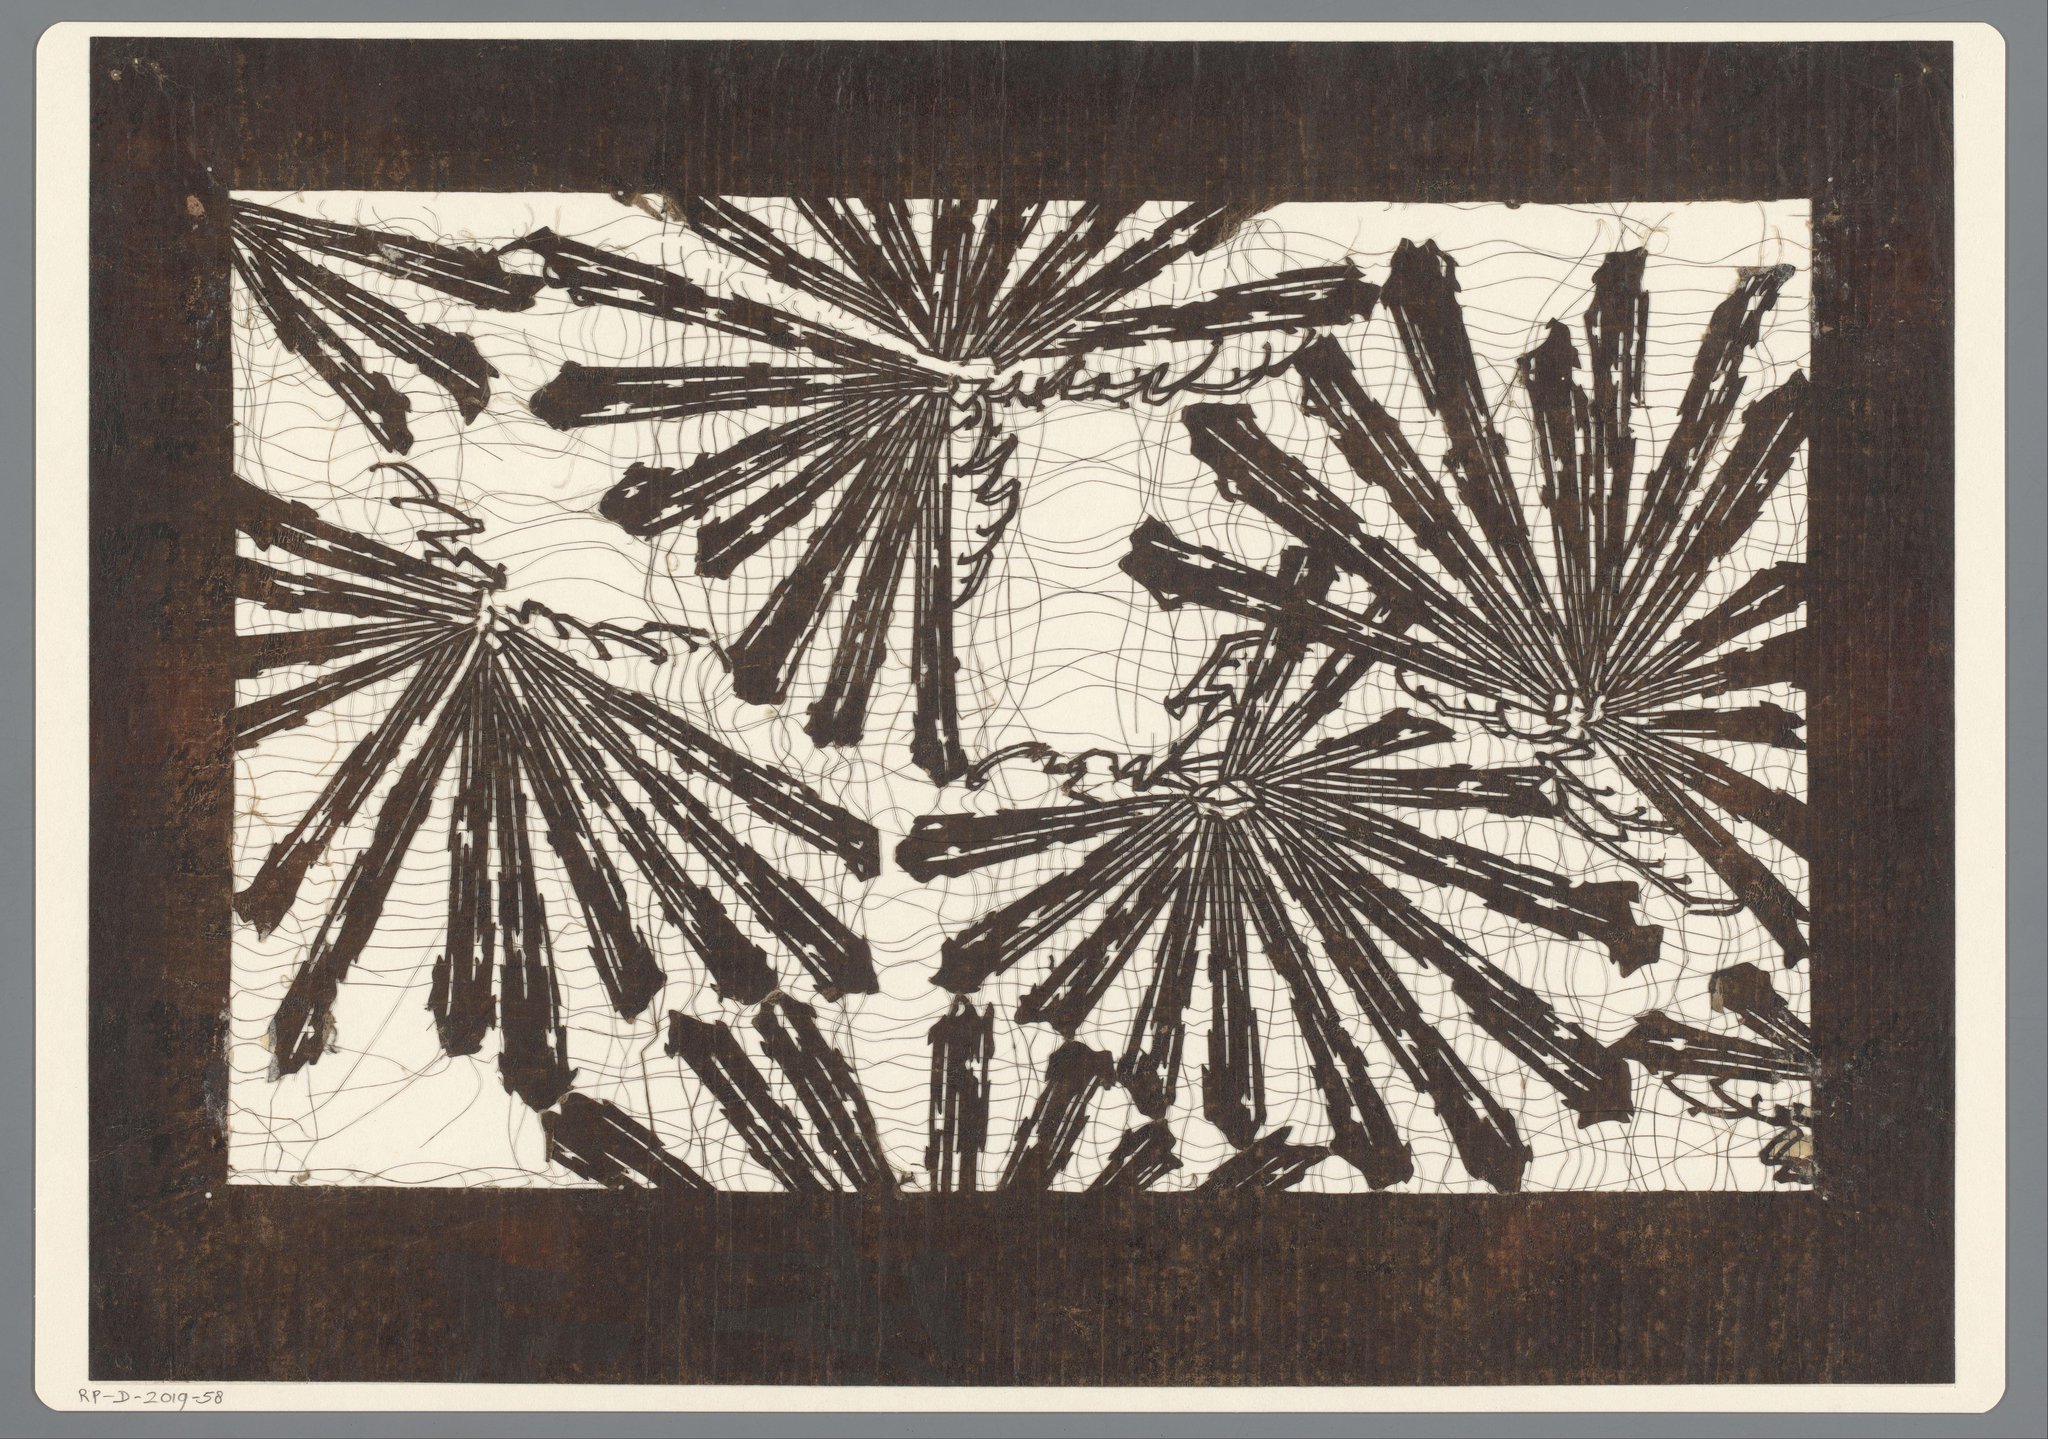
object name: katagami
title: Sjabloon met stralenvorm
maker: Anonymous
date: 1800-1909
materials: paper, silk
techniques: cutting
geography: japan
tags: ornament ~radiating forms, wheelforms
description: Japanse sjabloon (katagami) met een patroon van een kristalachtige stralenvorm.